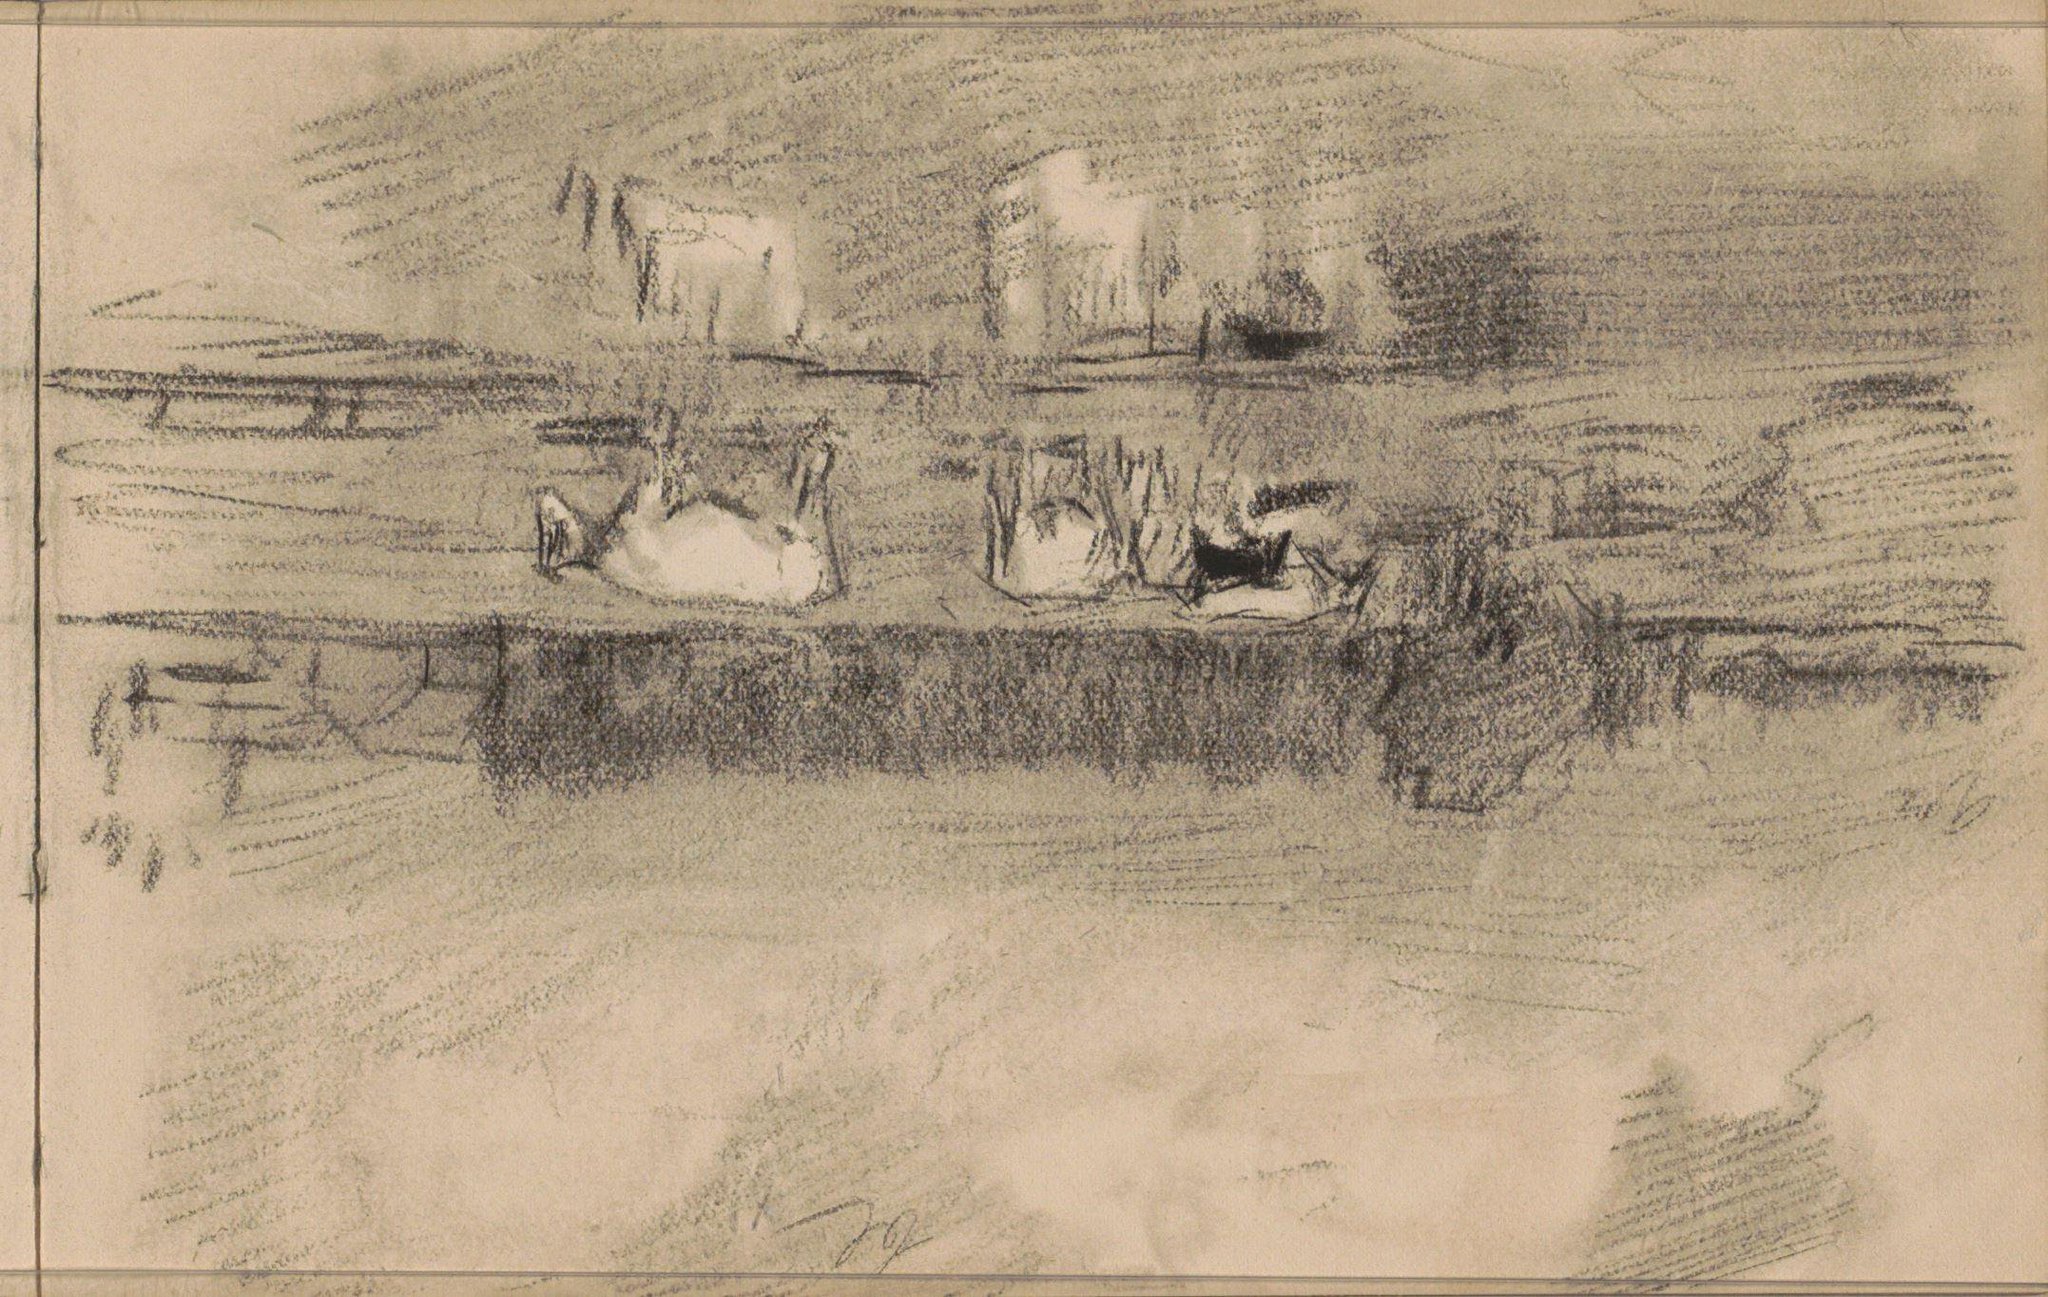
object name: sketchbook leaf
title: Koeien langs de waterkant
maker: johan antonie de jonge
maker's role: draughtsman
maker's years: 1864-1927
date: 1909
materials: chalk, paper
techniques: stumping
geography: south holland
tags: swamp, inland marsh, fens, cow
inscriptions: kleurnotitie, handgeschreven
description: Koeien langs de waterkant. In de verte bebouwing. Blad 12 uit een schetsboek met 31 bladen.